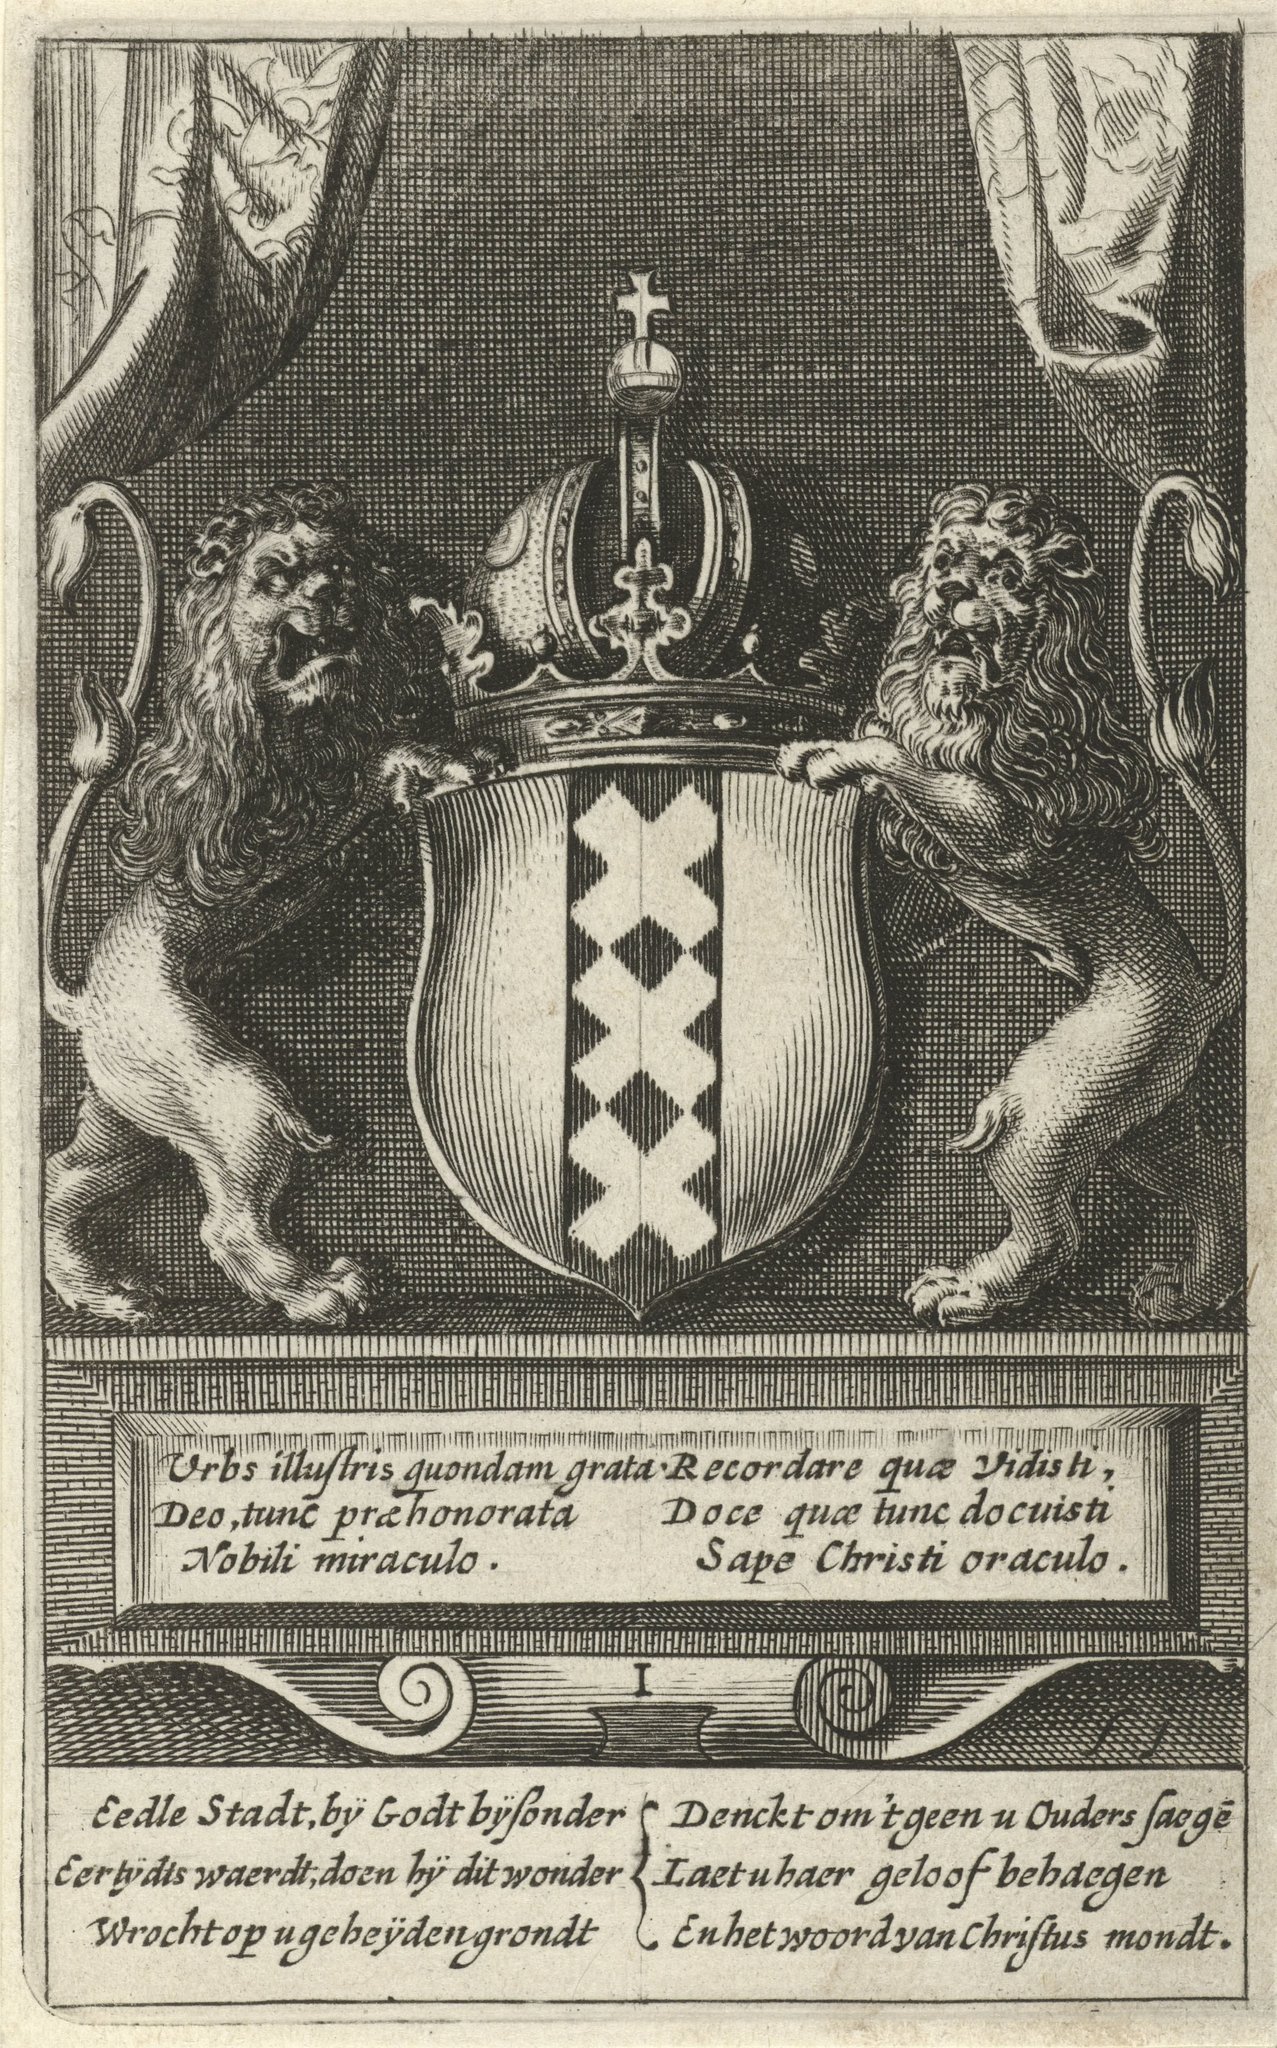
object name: book illustration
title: Mirakel van Amsterdam 1345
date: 1590-1633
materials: paper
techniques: engraving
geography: antwerp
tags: coat of arms (as symbol of the state, etc.)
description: Prent uit: Leonardus Marius, Amstelredams eer ende opcomen, door de denckwaerdighe miraklen aldaer geschied aen ende door het H. Sacrament des Altaers Anno 1345, Antwerpen, Hendrick Aertssens, 1639, afb. 1